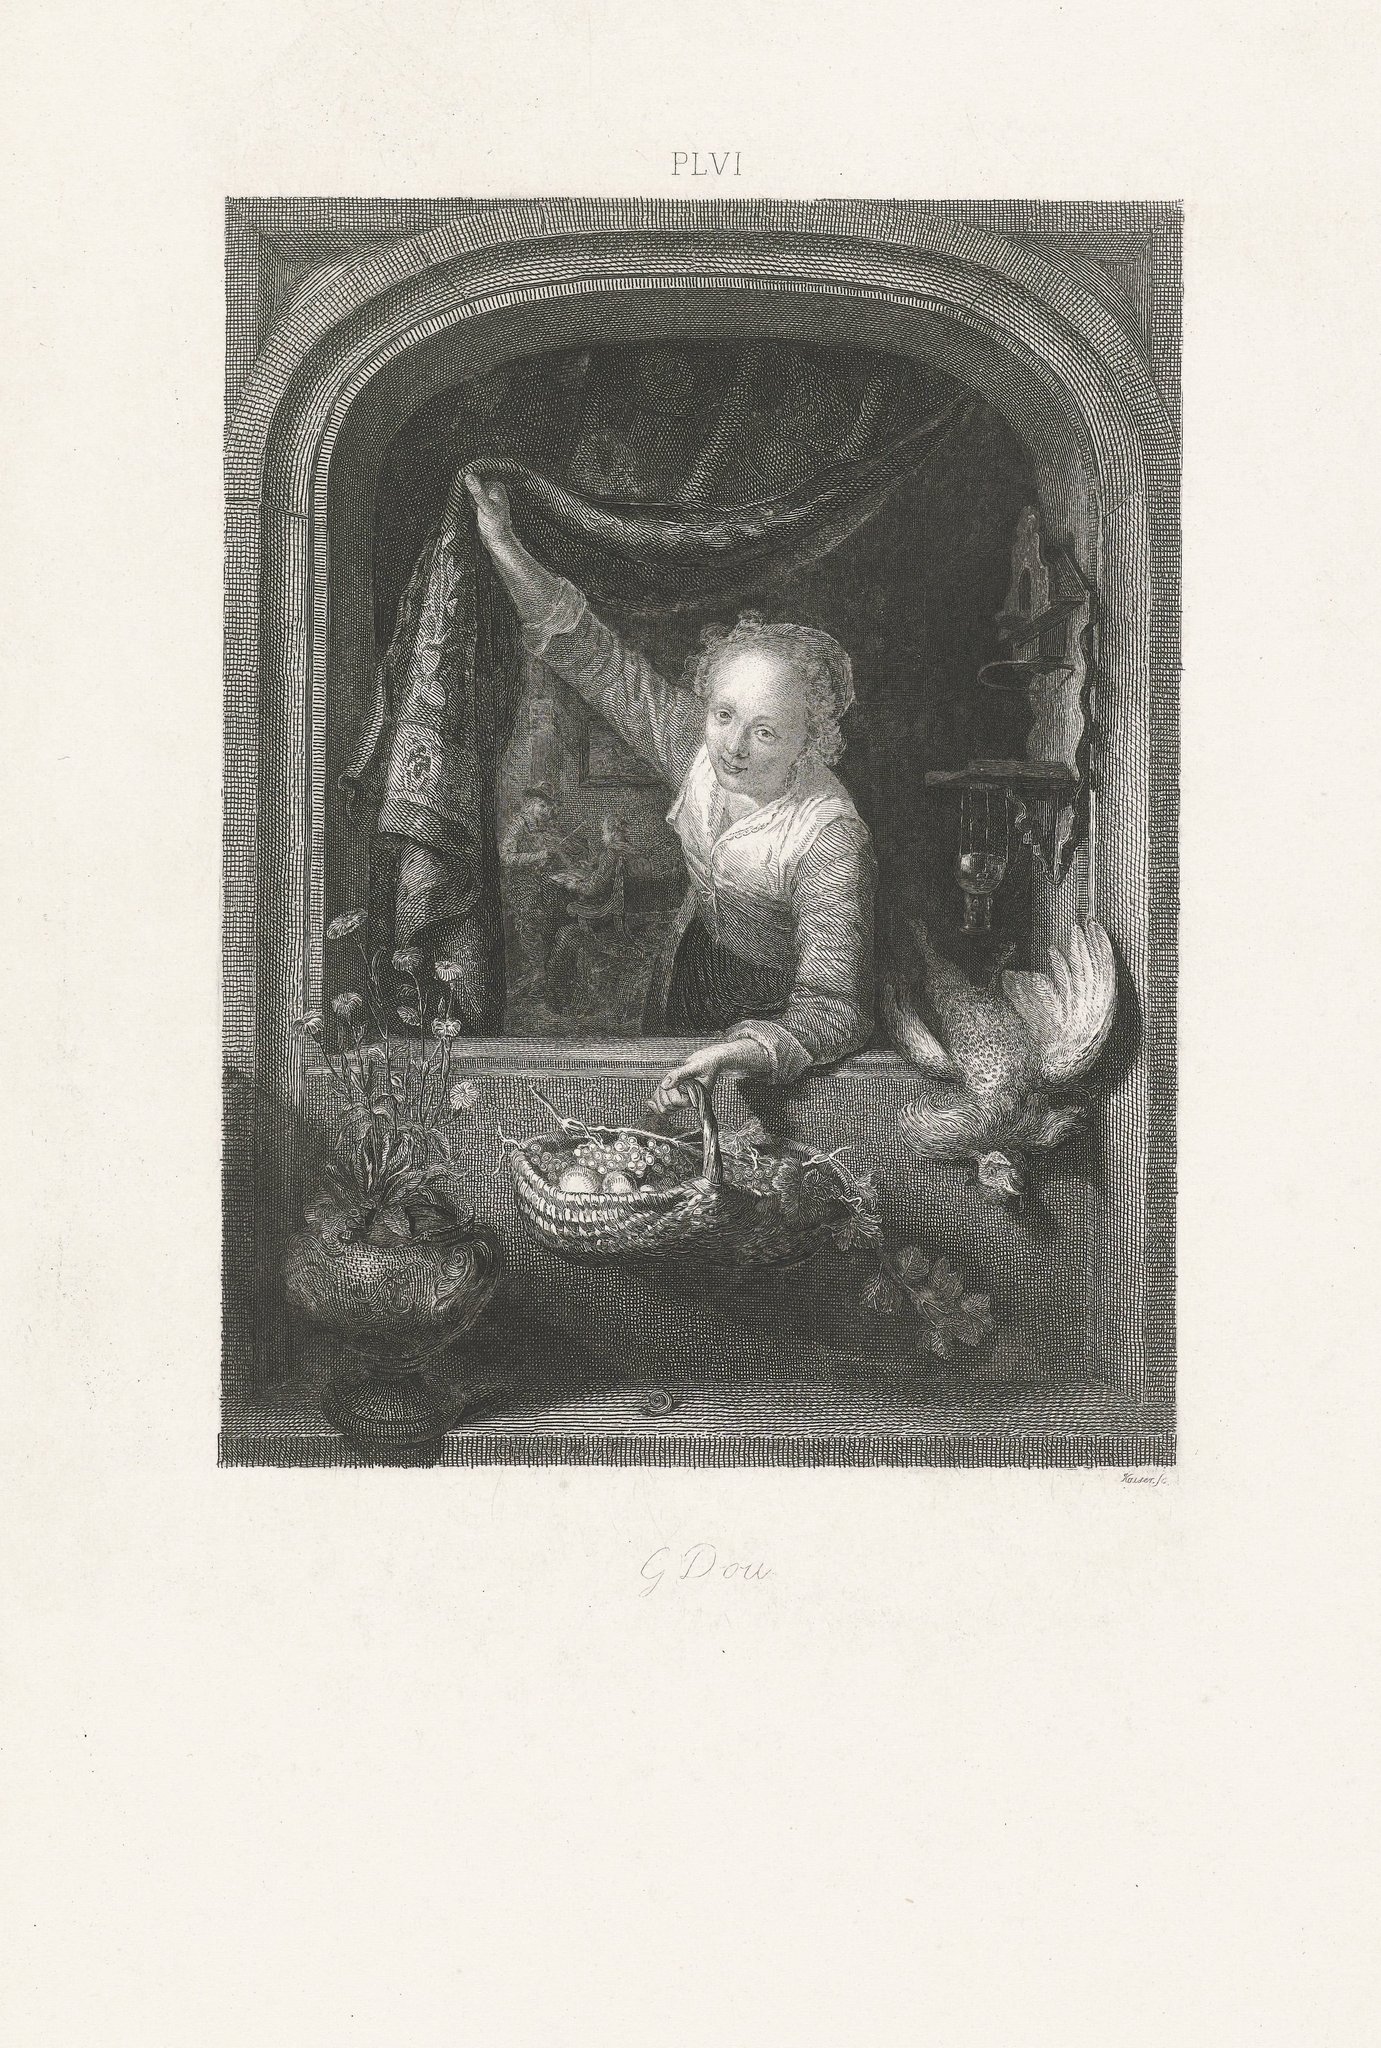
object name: print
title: Hollandse meesters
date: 1823-1900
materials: paper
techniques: etching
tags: window-seat, adolescent, young woman, maiden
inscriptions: collector's mark: Lugt 2228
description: Een meisje met een mand met fruit in haar linkerhand, kijkend uit een venster. Op de achtergrond twee figuren in een interieur, waarvan één met instrument. De prent maakt deel uit van een serie van 25 prenten naar Hollandse meesters. Boven de afbeelding: PL VI.